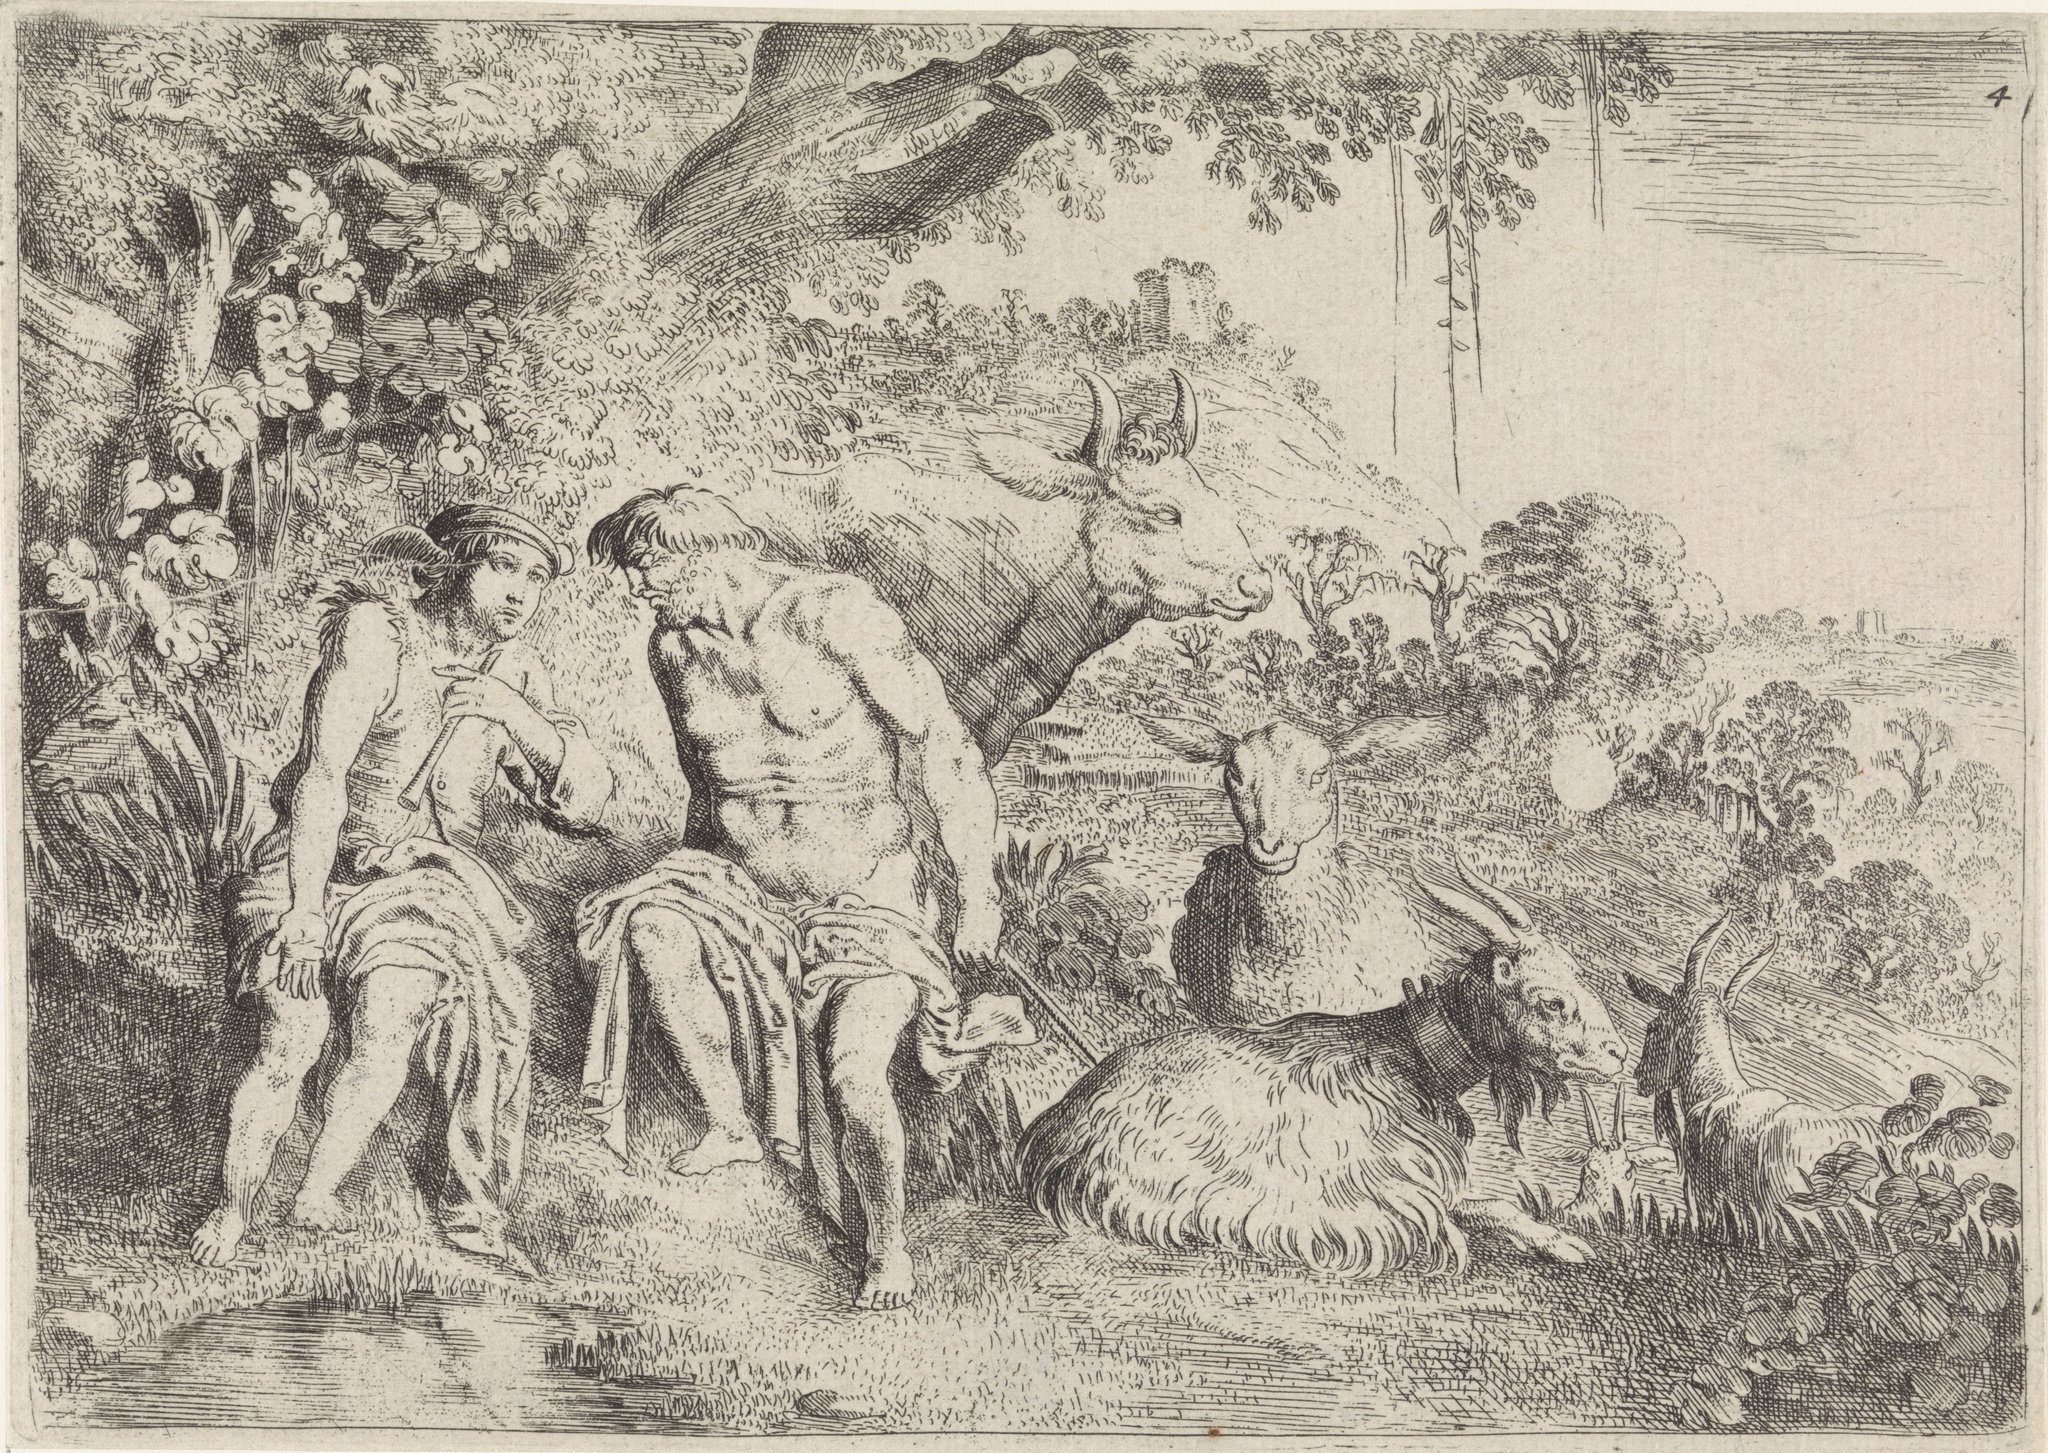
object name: print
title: Mercurius sust Argus in slaap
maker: moyses van wtenbrouck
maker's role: painter, print maker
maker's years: 1590-1647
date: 1618-1628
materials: paper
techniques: engraving, etching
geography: the hague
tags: mercury lulls argus into sleep by making music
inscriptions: collector's mark: Lugt 2610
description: Mercurius kijkt naar de slapende Argus. Hij heeft een fluit in zijn hand. Scène uit Ovidius’ Metamorfosen (Met. I, 682-687).